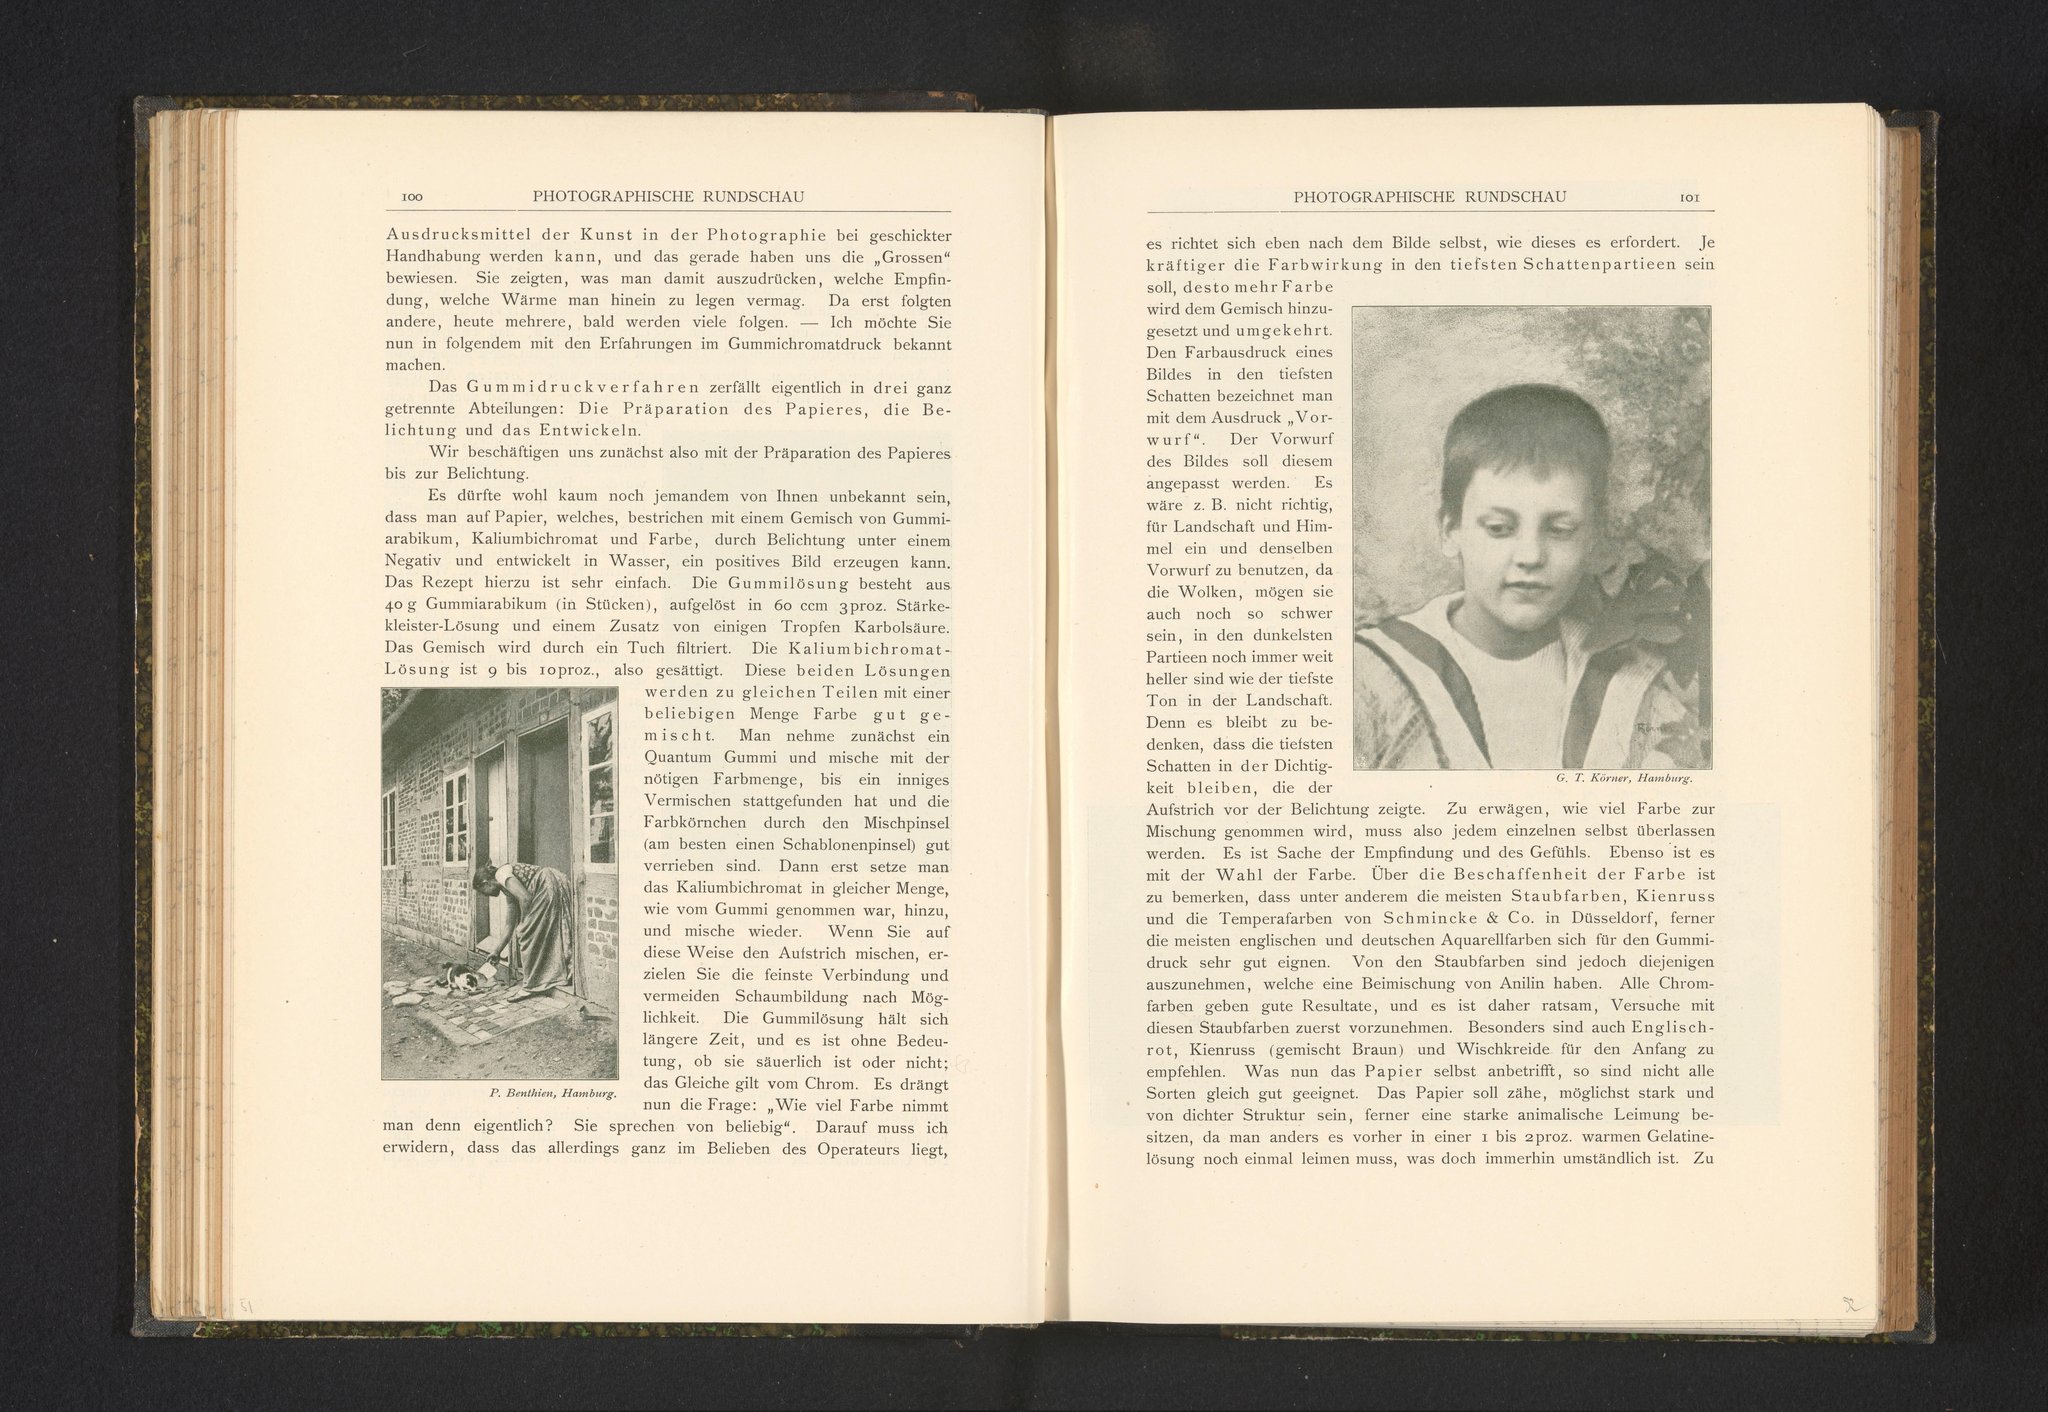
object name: page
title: Vrouw geeft een kat drinken voor een woning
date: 1893-1898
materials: paper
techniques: autotype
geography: hamburg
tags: cat, housing, feeding wild animals